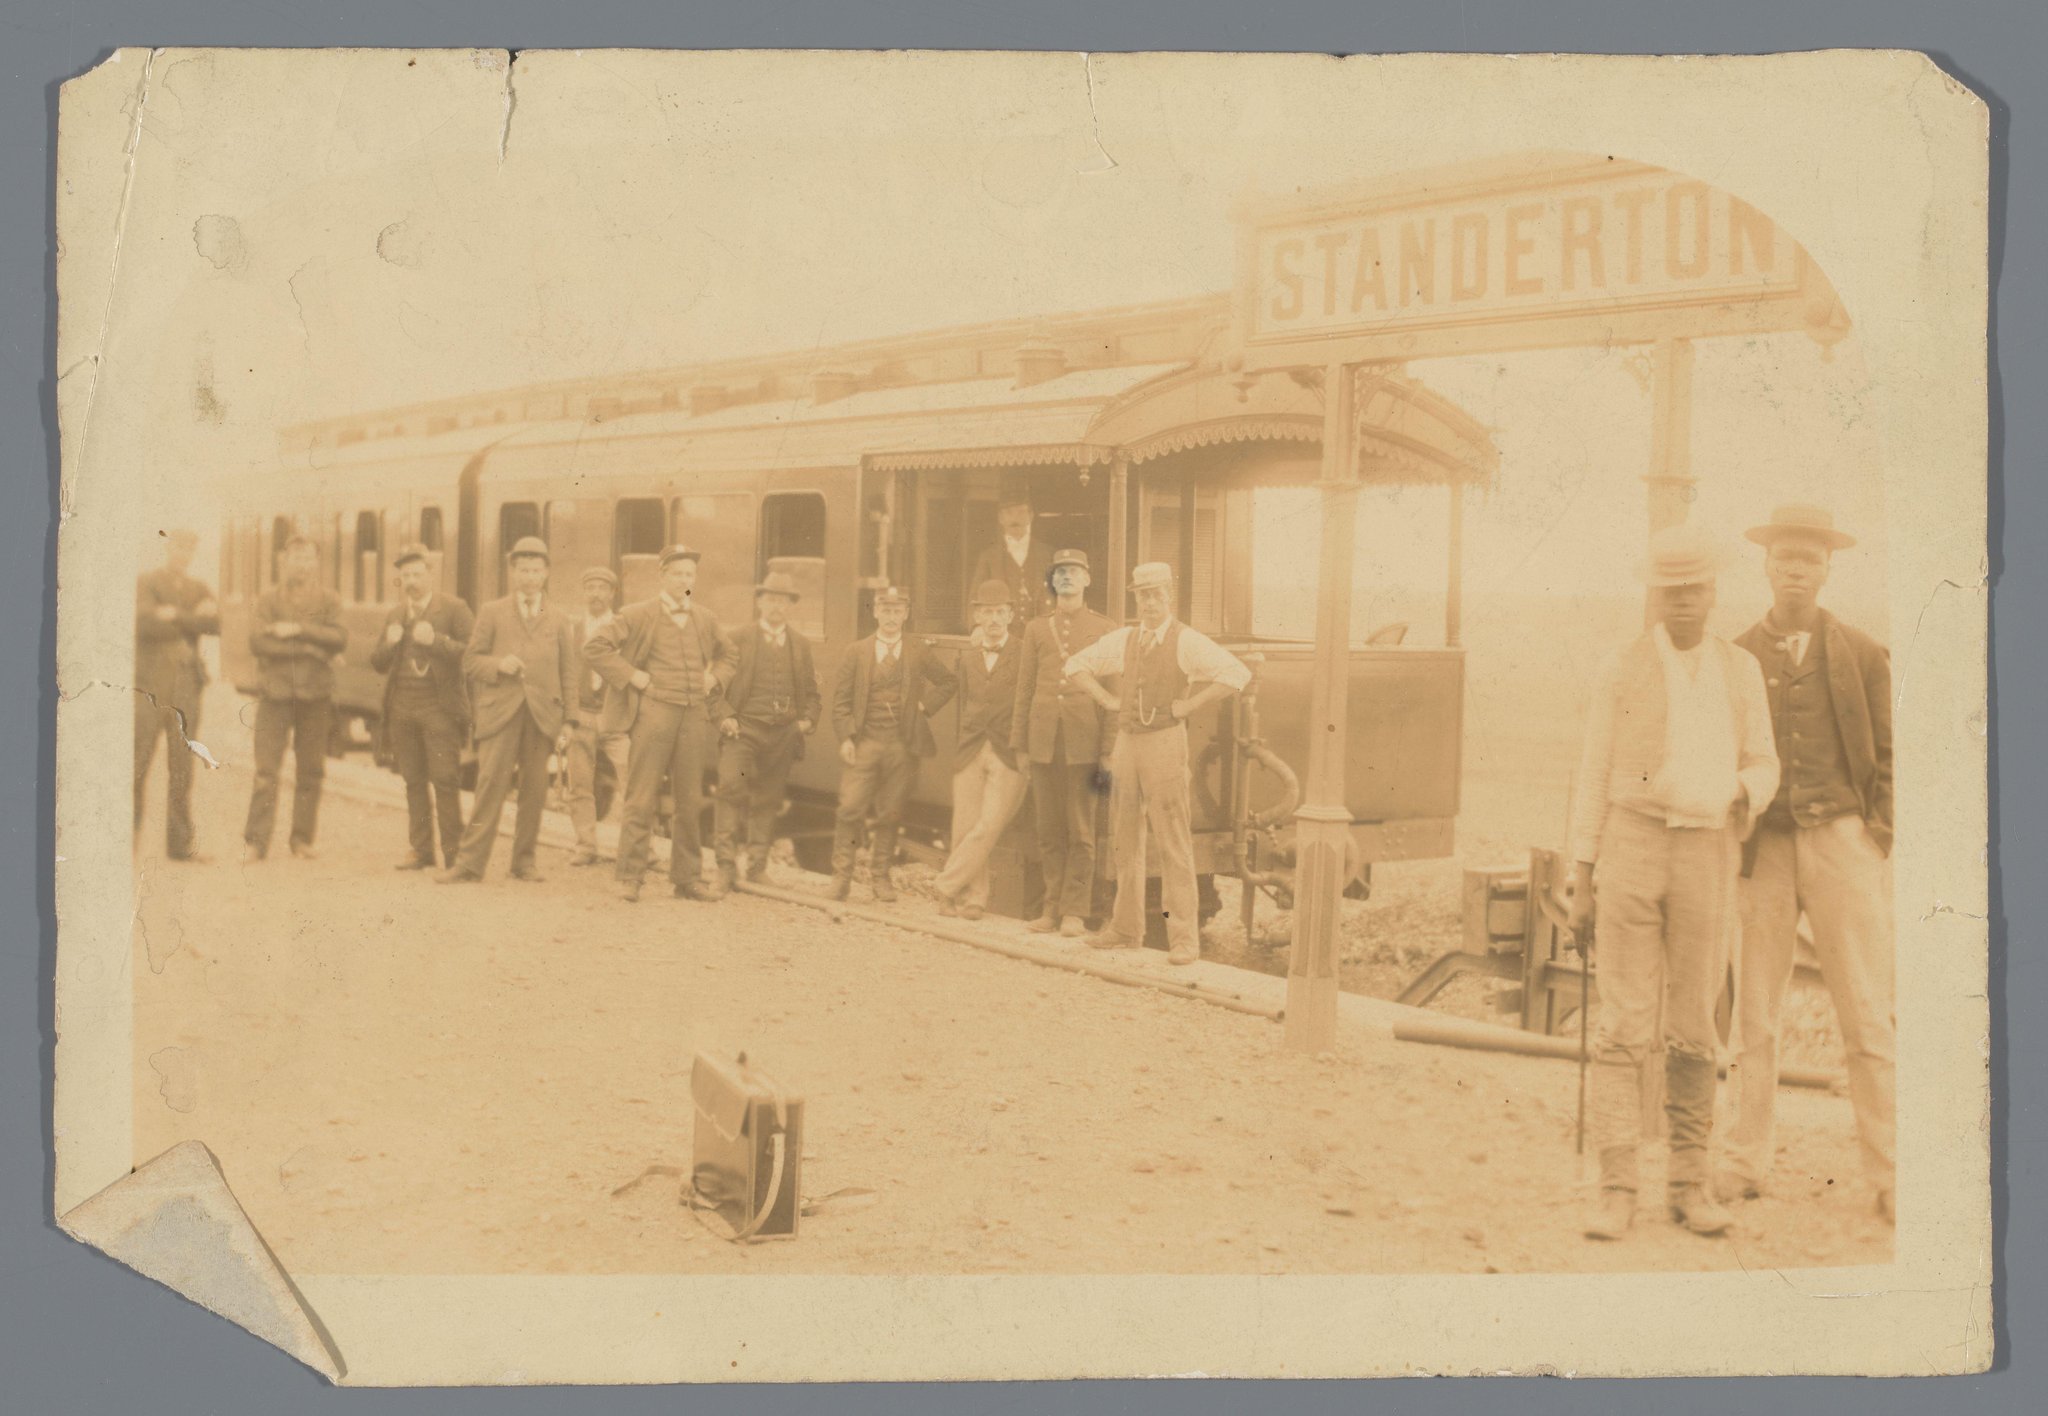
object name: photograph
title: Station Standerton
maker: a. happe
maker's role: bediende, fotograaf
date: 1900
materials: paper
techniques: photography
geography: south africa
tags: vaalbank, president, paul kruger, zuid-afrika, boerenoorlog